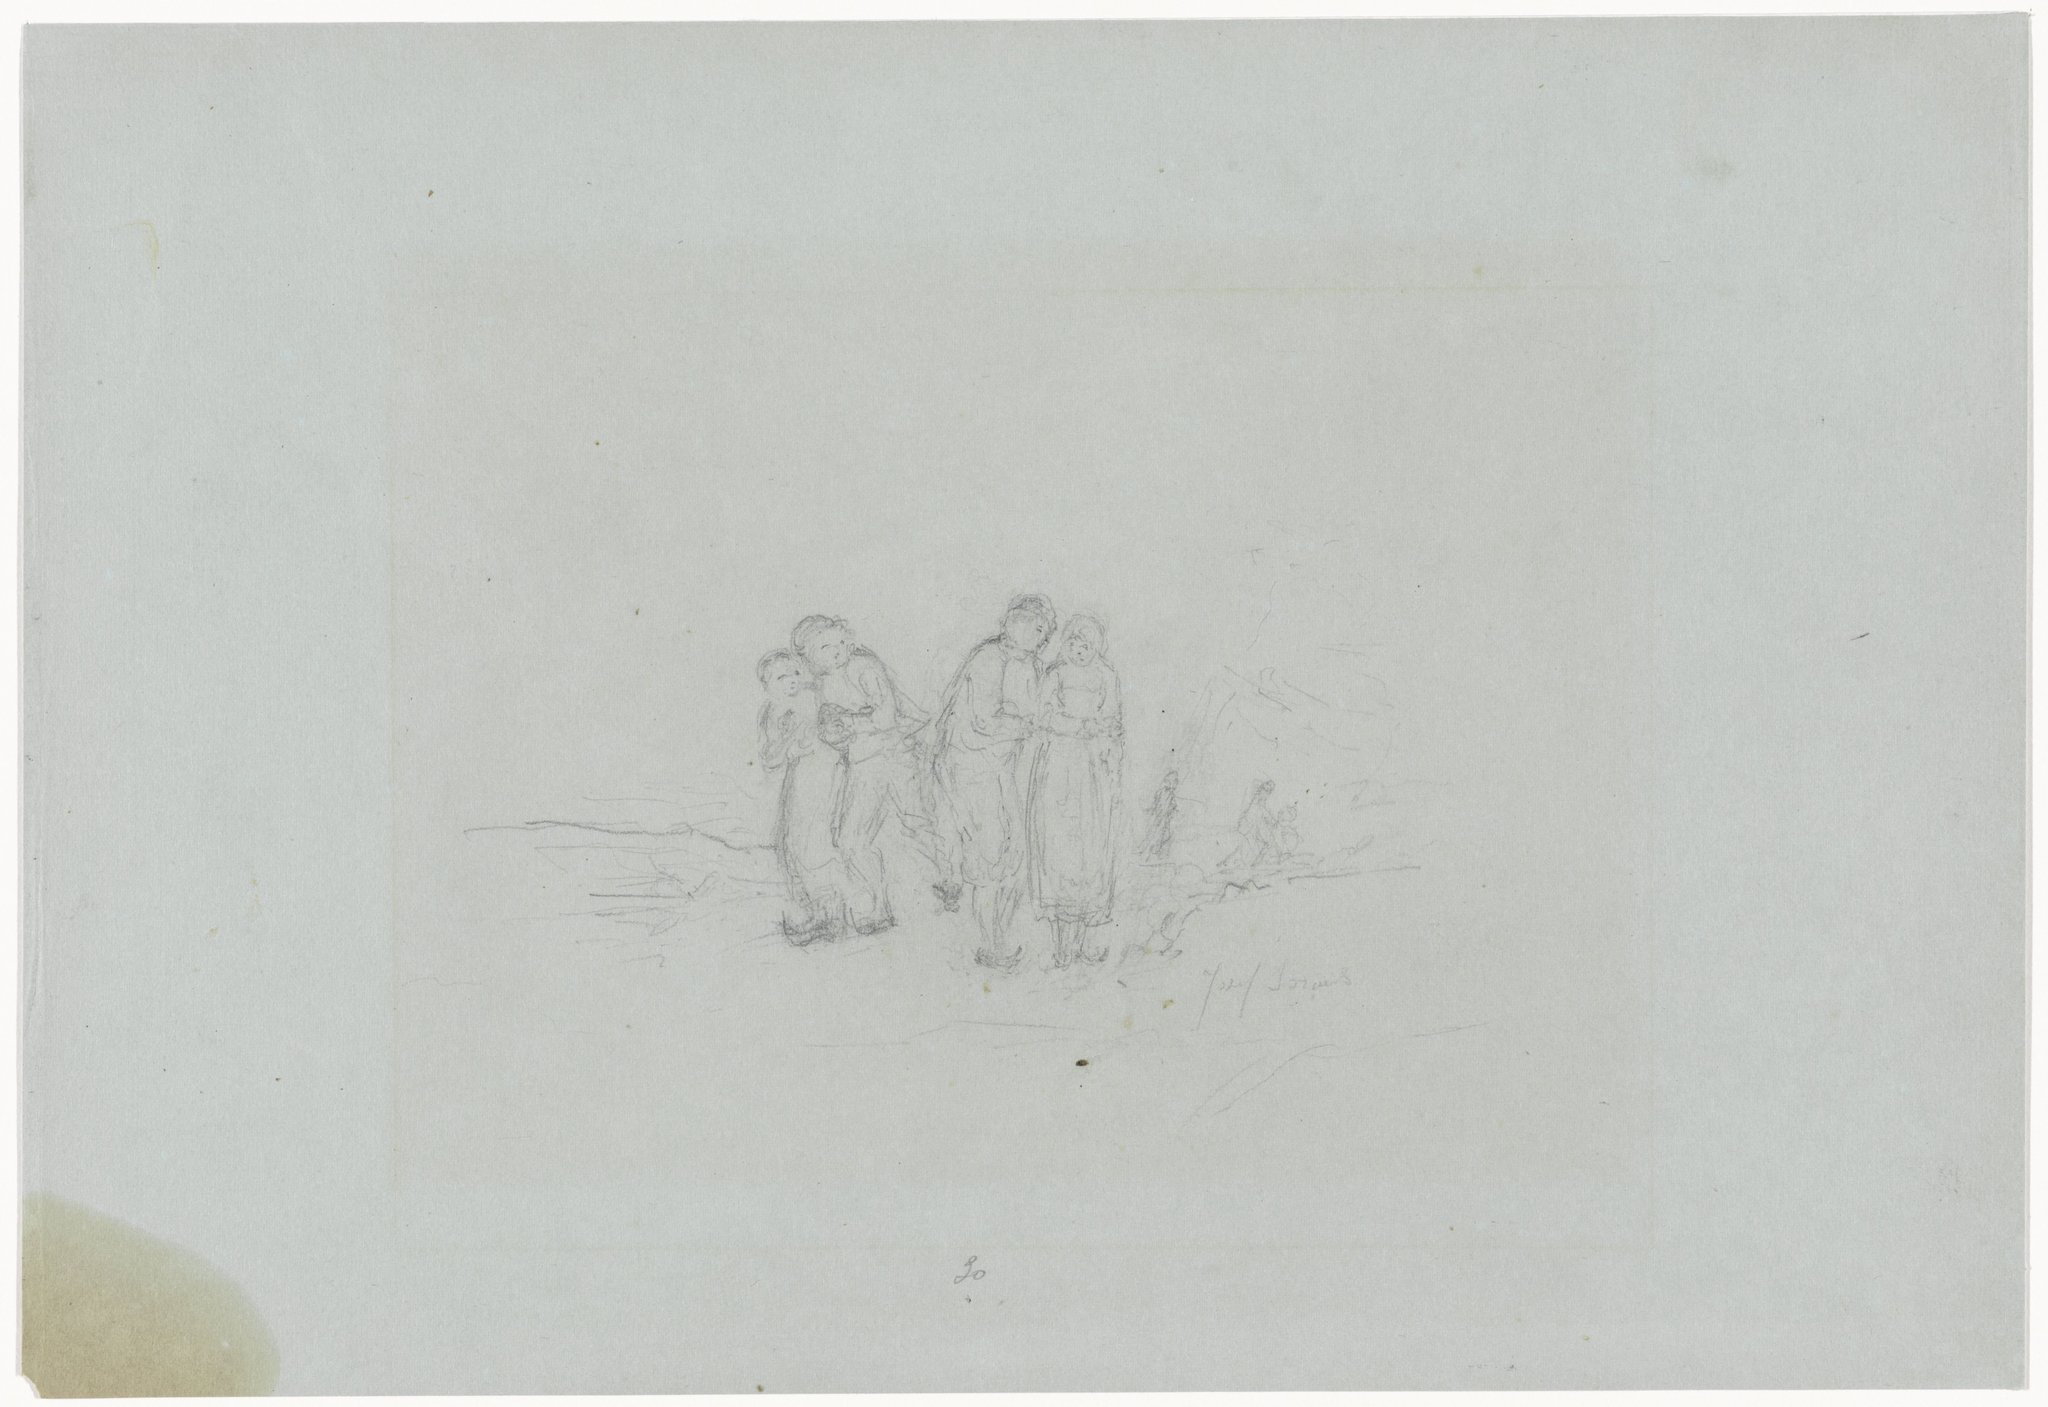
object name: drawing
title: Schaatsenrijders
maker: jozef israëls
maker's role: draughtsman, painter, print maker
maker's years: 1824-1911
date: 1834-1911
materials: paper, pencil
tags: skates (winter sports)